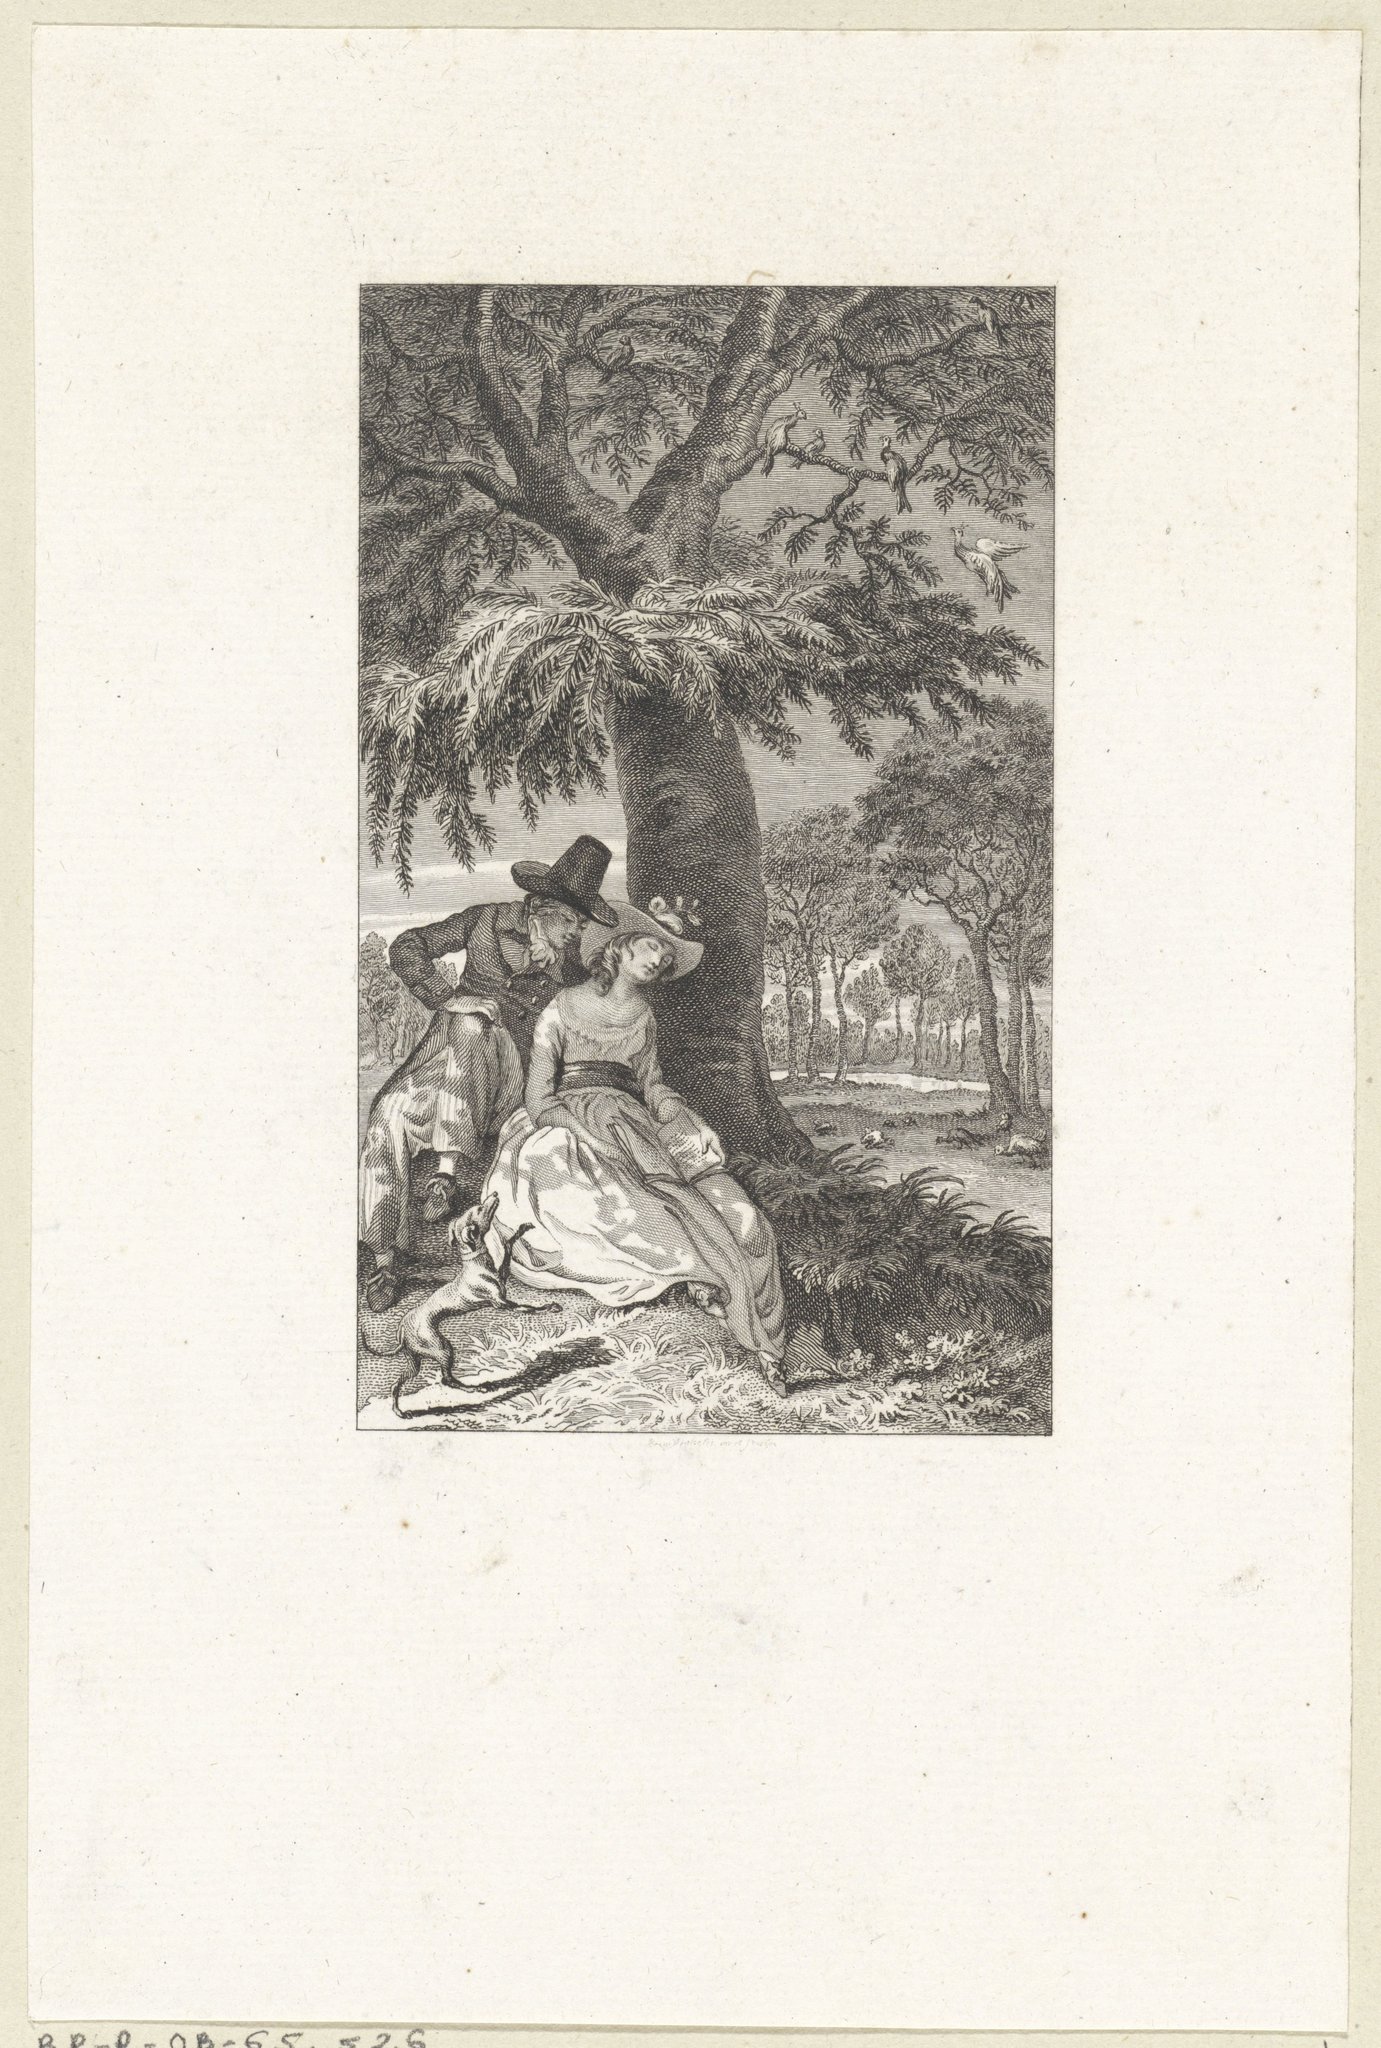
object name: print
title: Reinhart en zijn vrouw rusten in de schaduw van een boom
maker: reinier vinkeles (i)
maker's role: draughtsman, print maker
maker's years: 1741-1816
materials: paper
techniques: engraving, etching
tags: trees, landscapes, book, dog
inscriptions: collector's mark: Lugt 240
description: Latere staat van prent gebruikt in: Post, Elisabeth Maria. Reinhart, of Natuur en Godsdienst. 3 dln. 1e druk. Amsterdam: Johannes Allart, 1791-1792, dl. 3 (1792), p. 44. En in: Post, Elisabeth Maria. Reinhart, of Natuur en Godsdienst. 3 dln. 2e druk. Amsterdam: Johannes Allart, 1798-1802, dl. 3 (1802), p. 44.